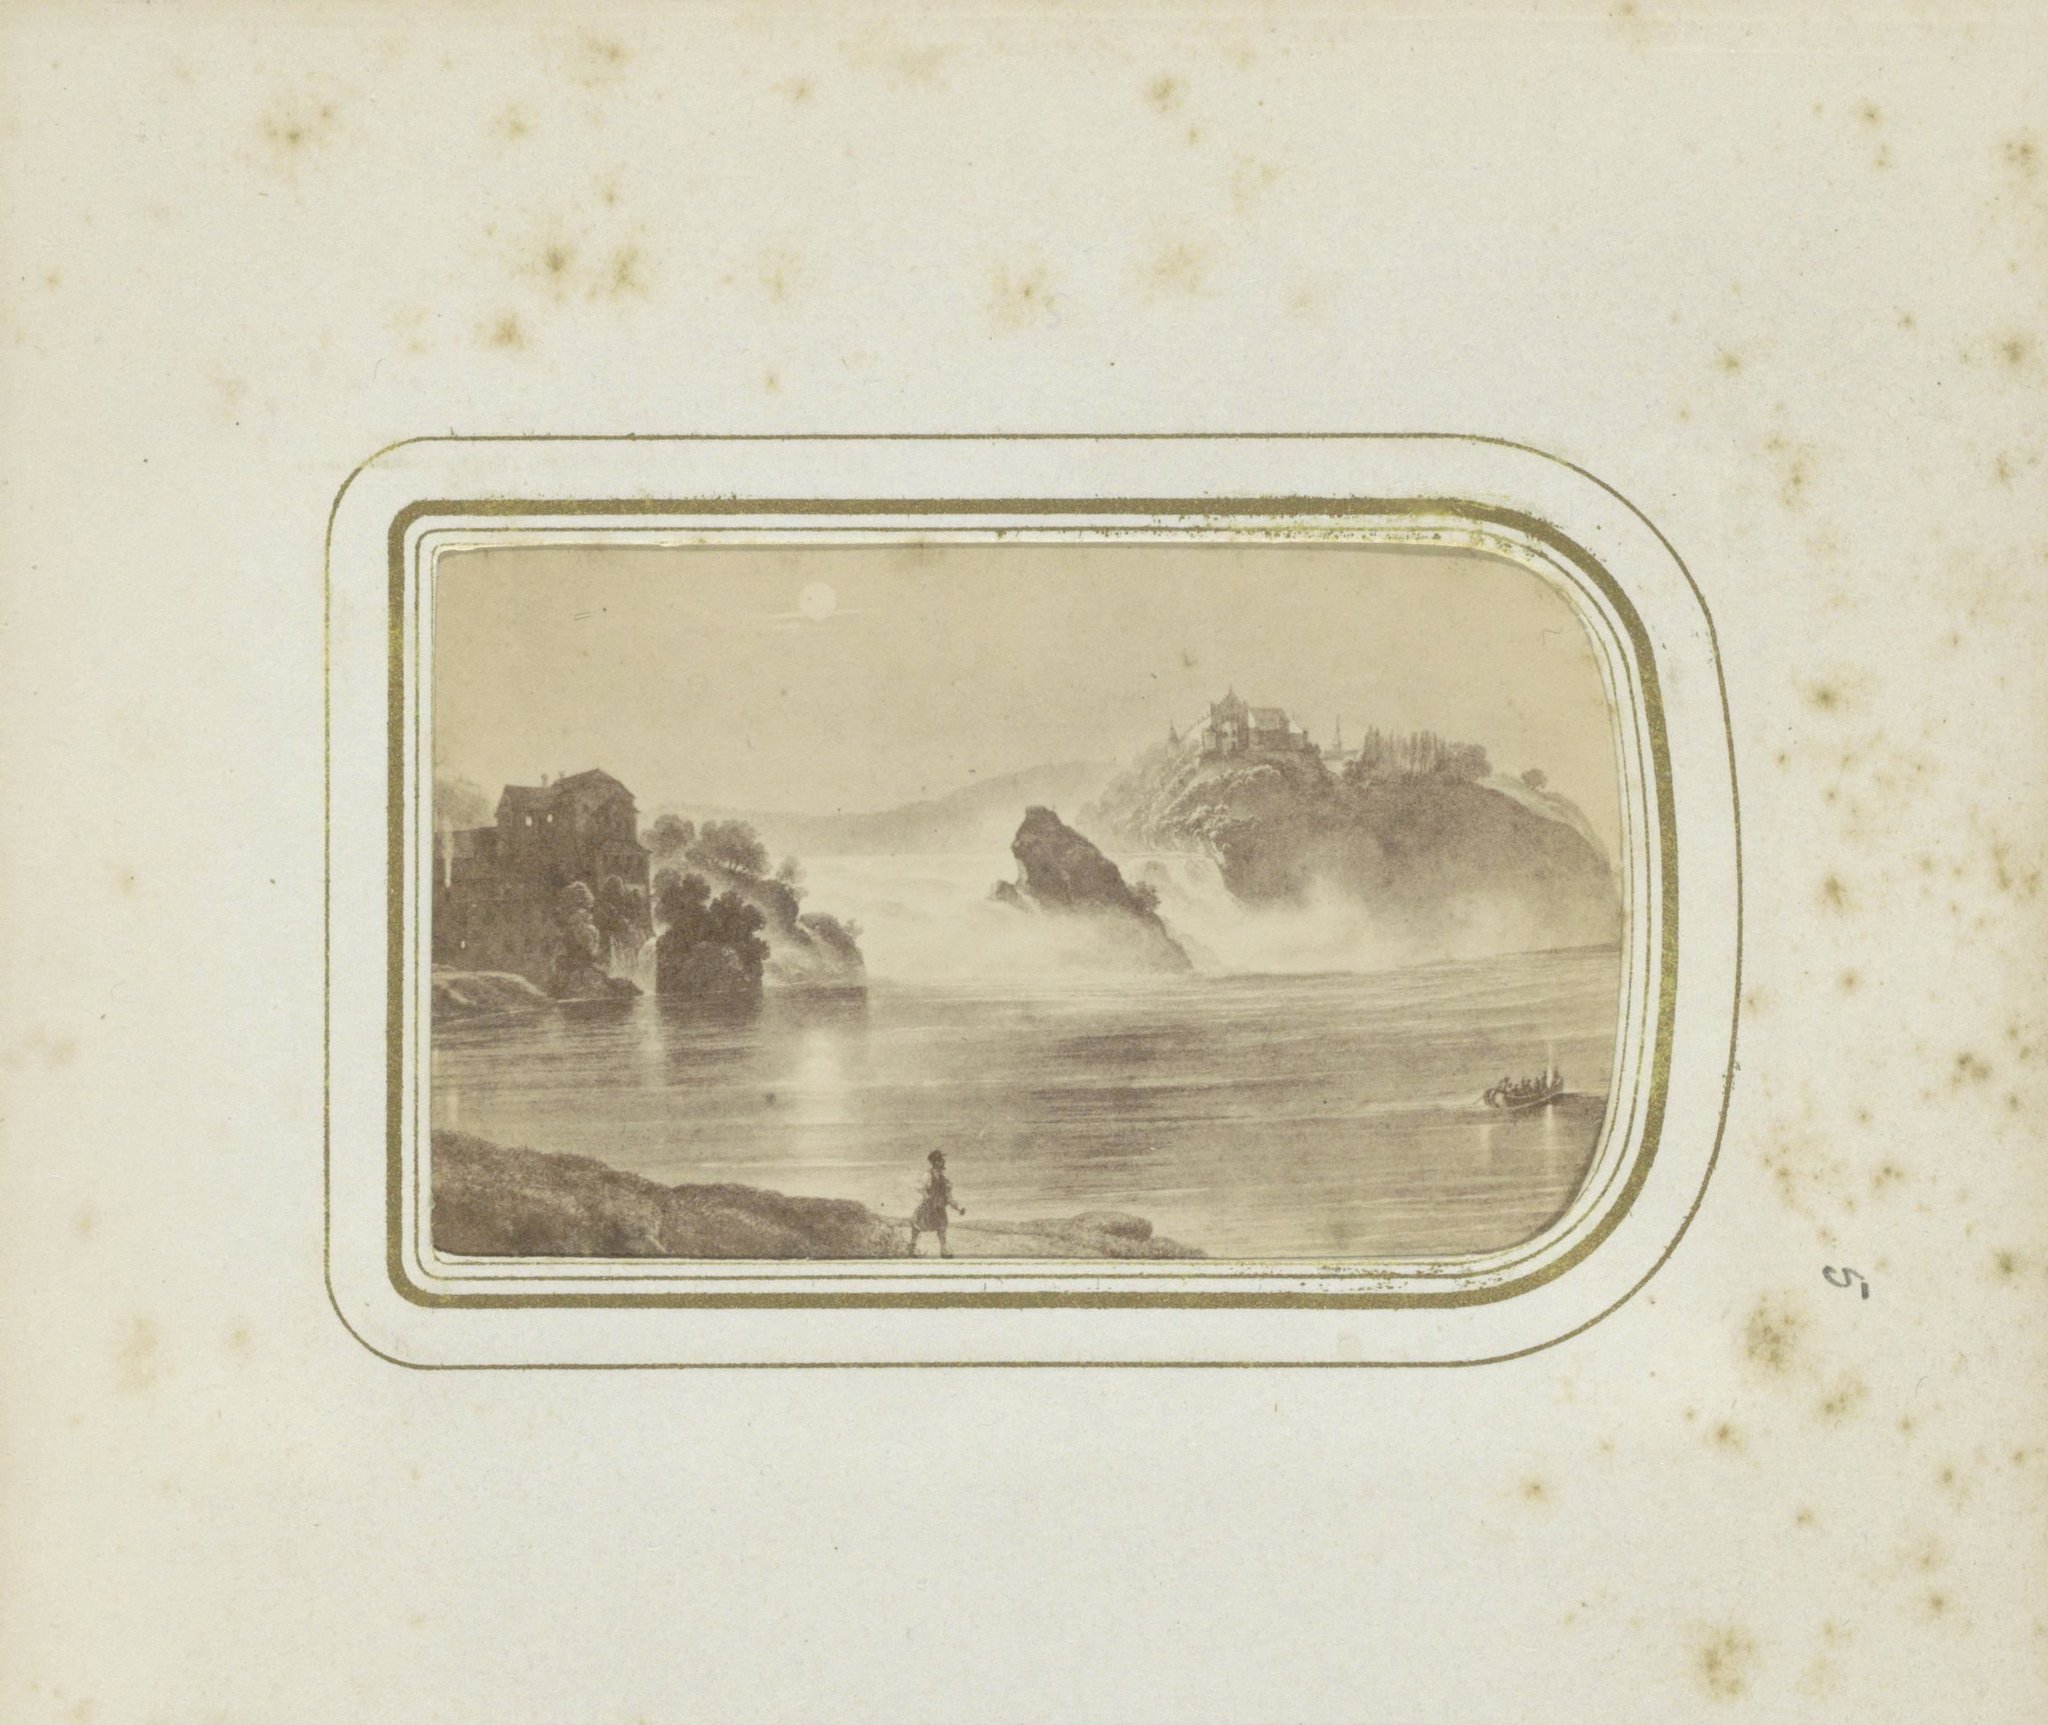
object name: reproduction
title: Fotoreproductie van een prent met een gezicht op de watervallen van Schaffhausen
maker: Anonymous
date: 1864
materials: paper, photographic support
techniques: albumen print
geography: switzerland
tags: travelling; tourism, waterfall (+ landscape with figures, staffage)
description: Onderdeel van Fotoalbum van een reis door Zwitserland, Oostenrijk en Duitsland door de Nederlandse familie Derkinderen.